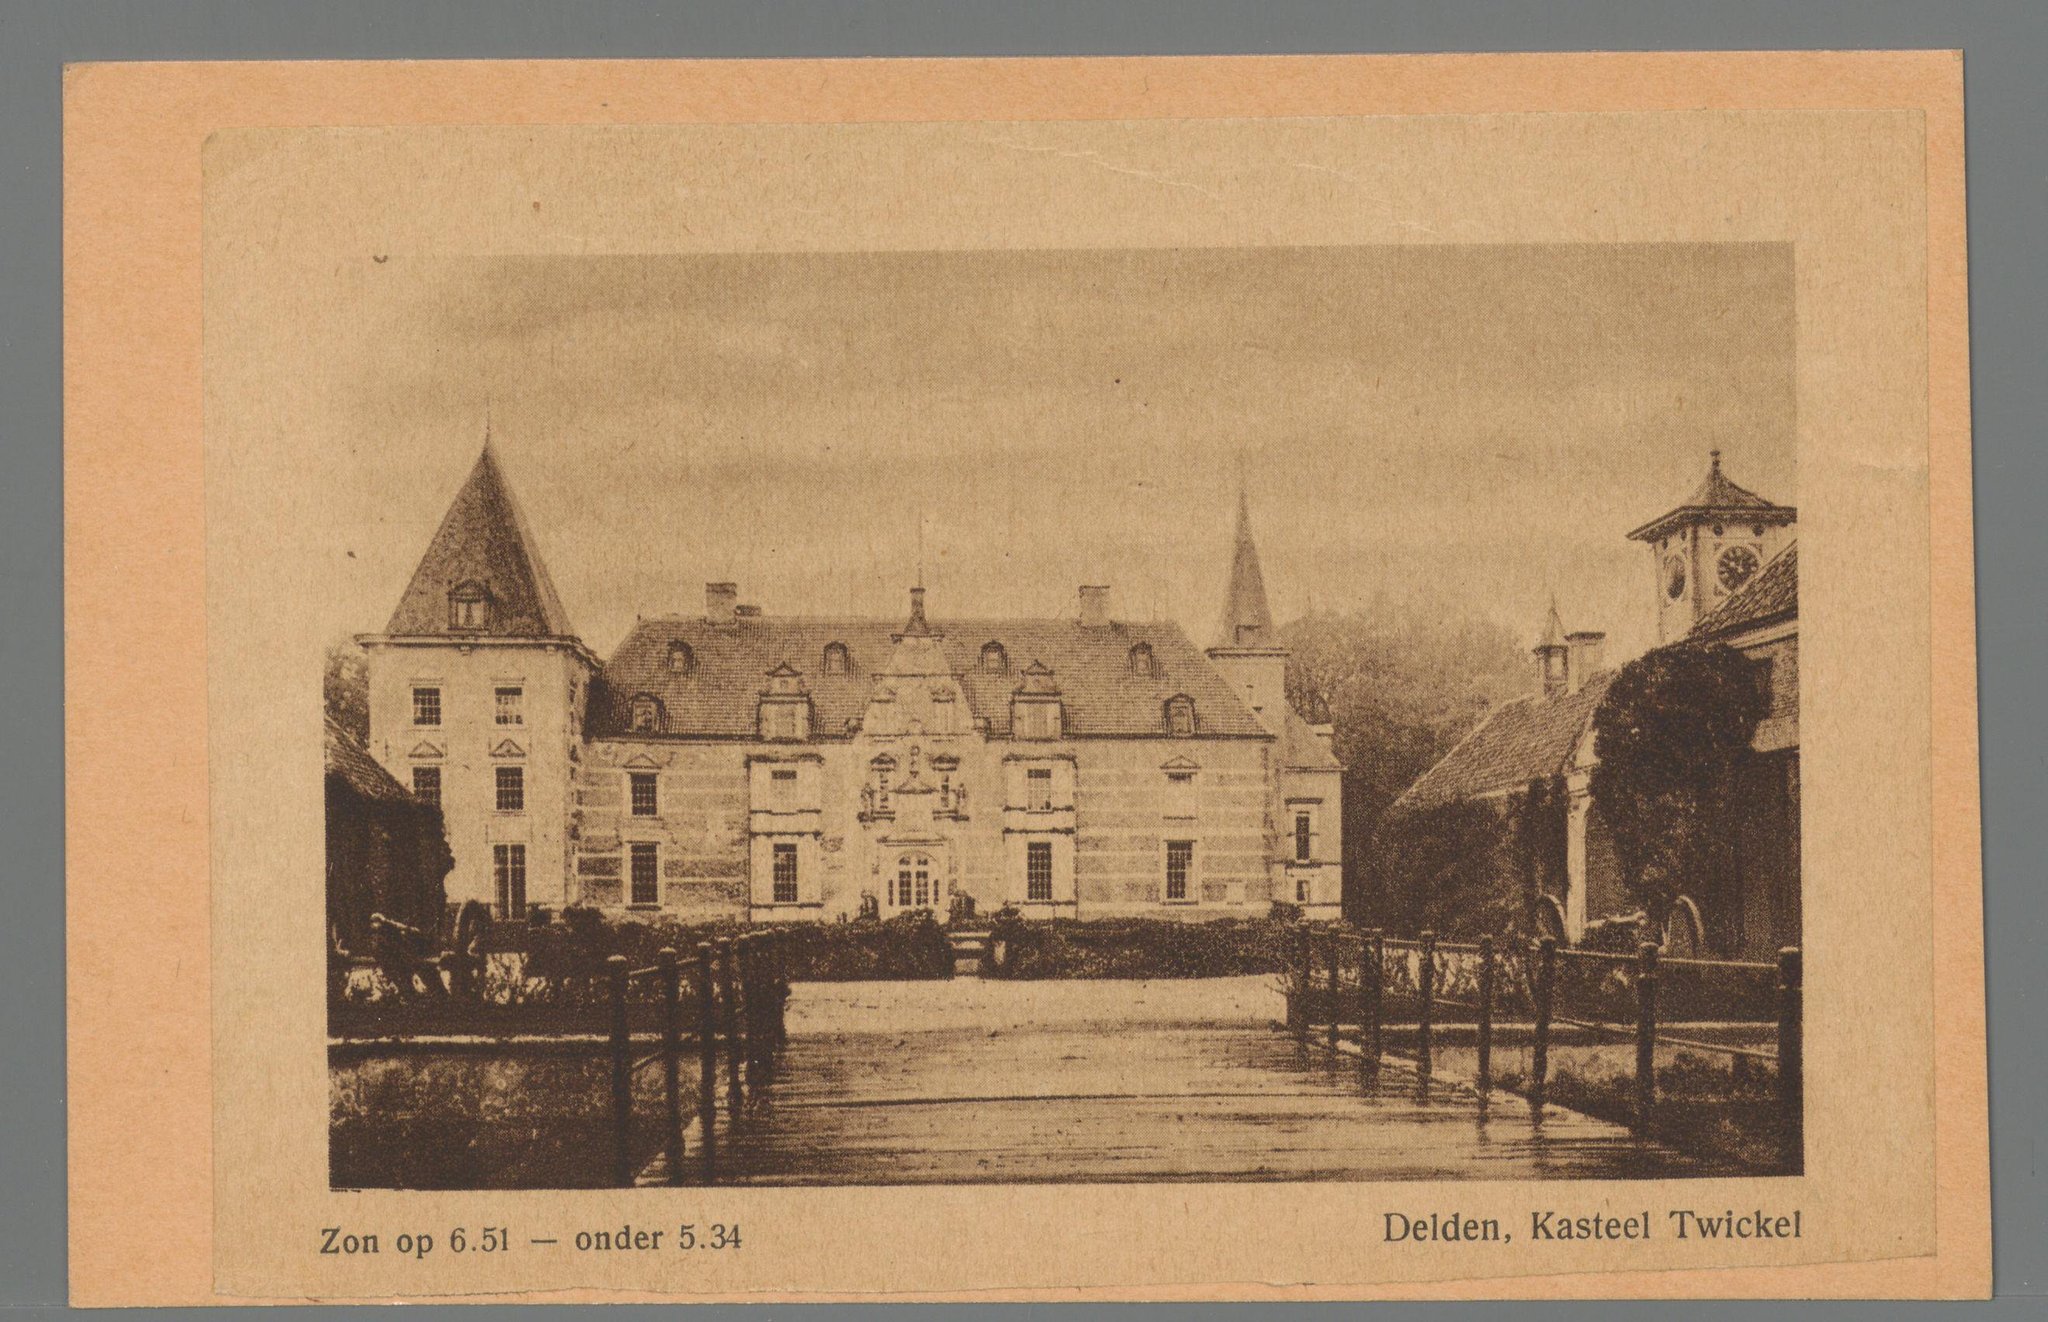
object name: photomechanical print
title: Delden, Kasteel Twickel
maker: Anonymous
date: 1895-1930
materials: cardboard, paper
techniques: rotogravure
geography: delden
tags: castle